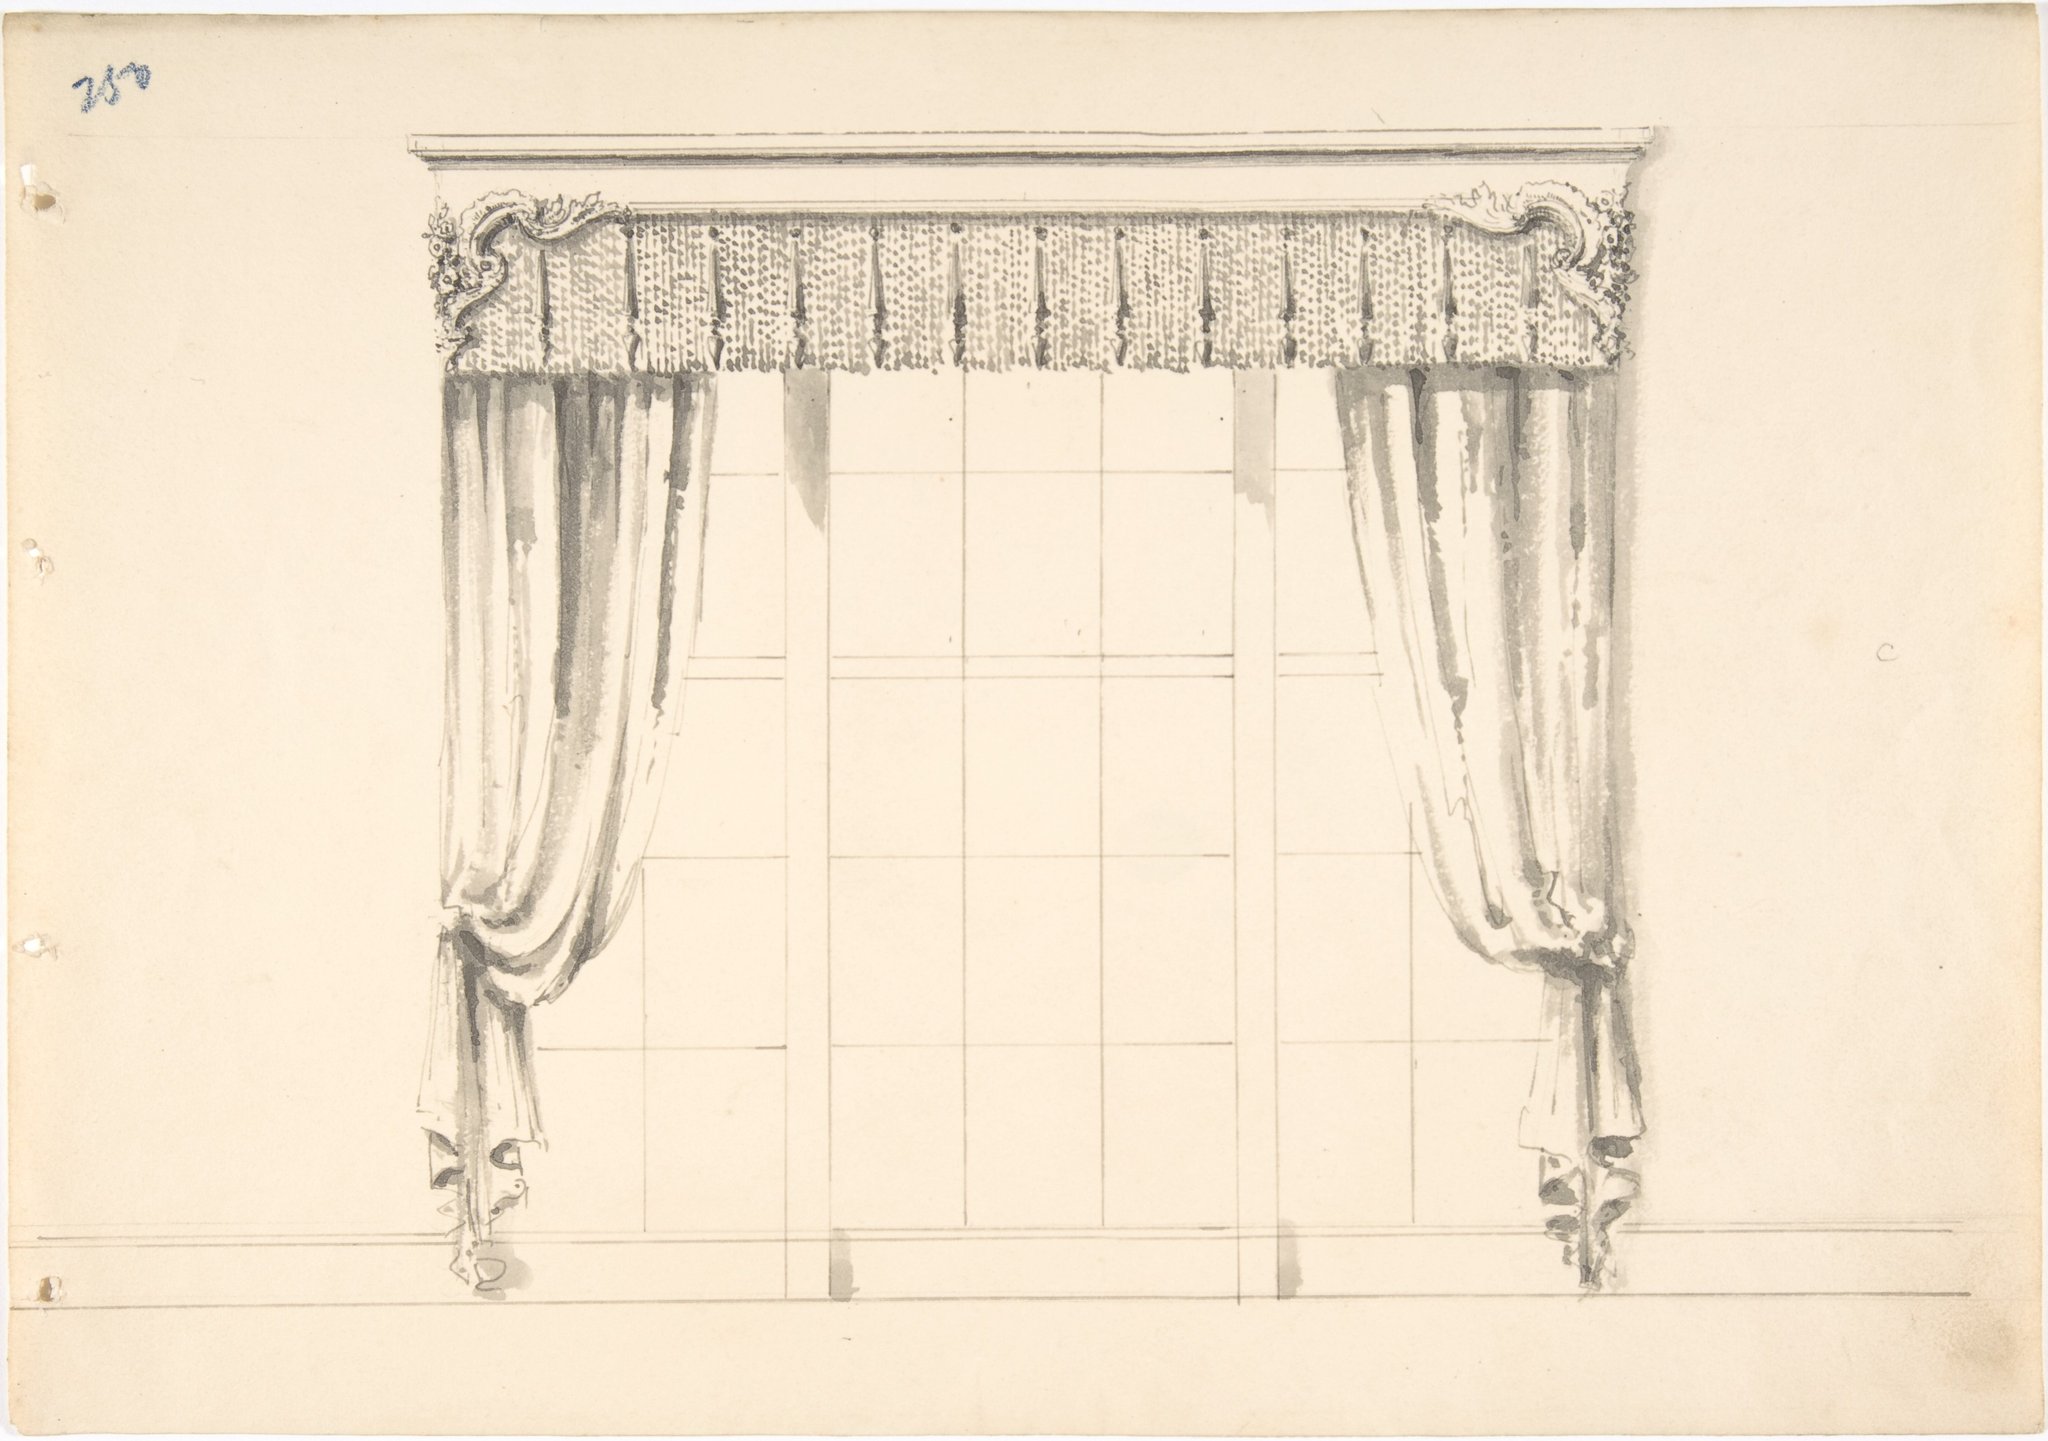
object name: drawing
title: Design for Fringed Curtains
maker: anonymous, british, 19th century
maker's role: artist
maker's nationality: british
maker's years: 1800-1900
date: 1801-1833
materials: ink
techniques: brush, pen, wash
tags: windows,curtains